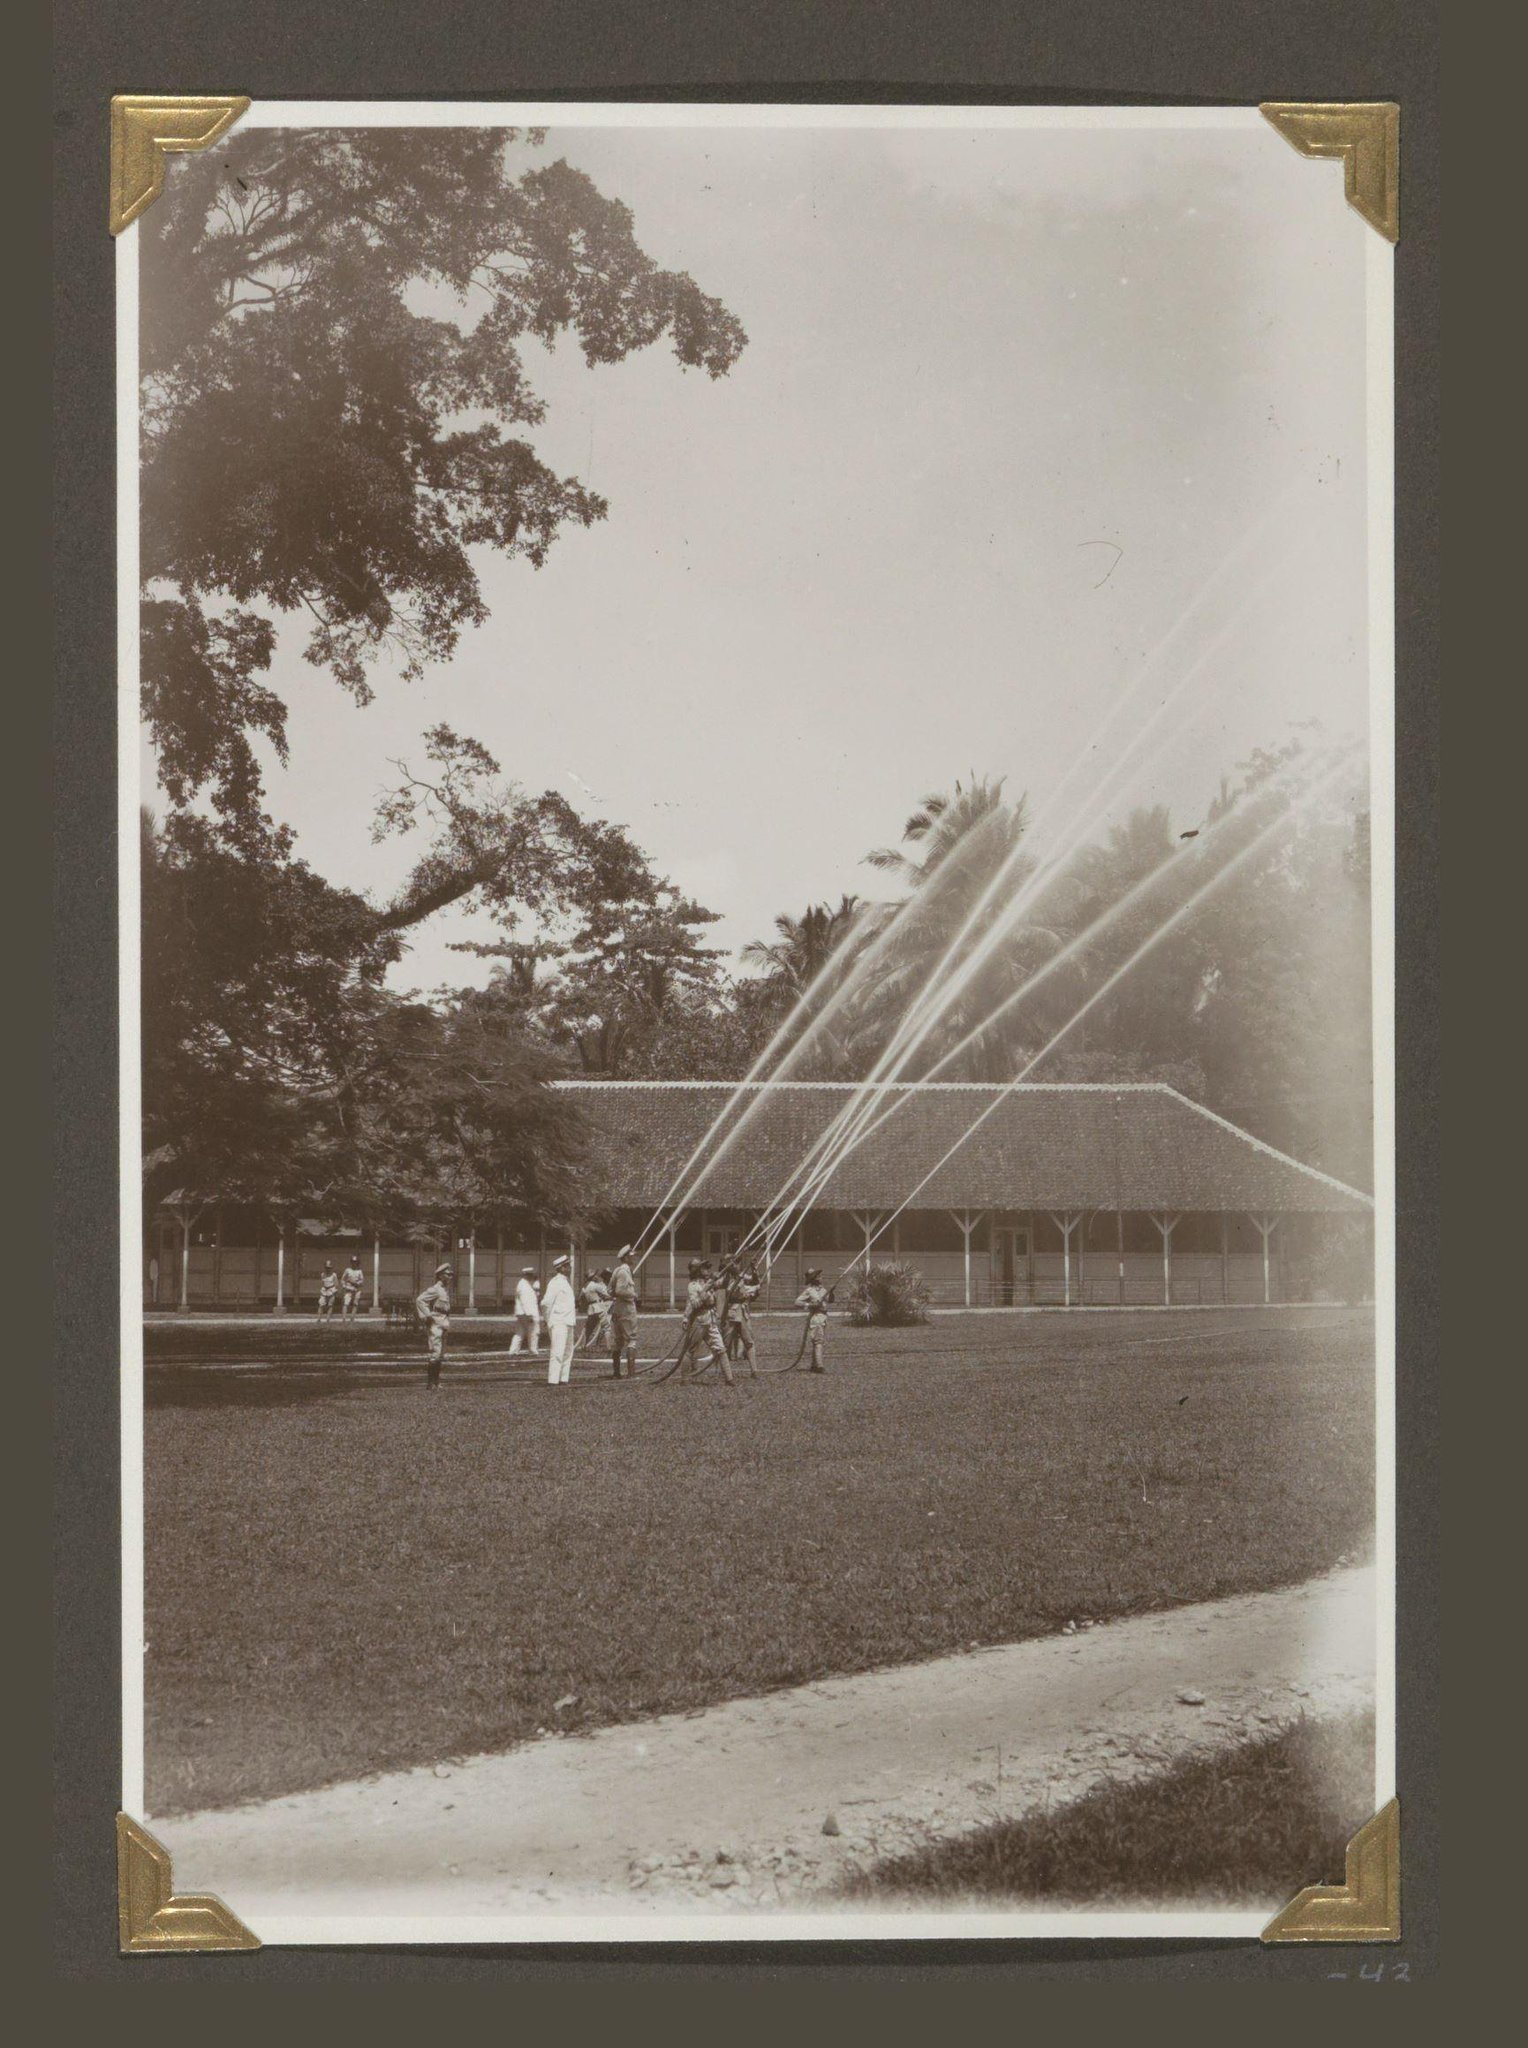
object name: photograph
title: Met alle stralen onder de hoogste spanning wordt water gegeven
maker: Anonymous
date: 1932-1933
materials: photographic support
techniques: gelatin silver print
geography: lampung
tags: fire-fighting, firemen, police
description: Onderdeel van Herinneringsalbum voor F.J. Junius, vertrekkend resident van Lampong (Zuid-Sumatra).